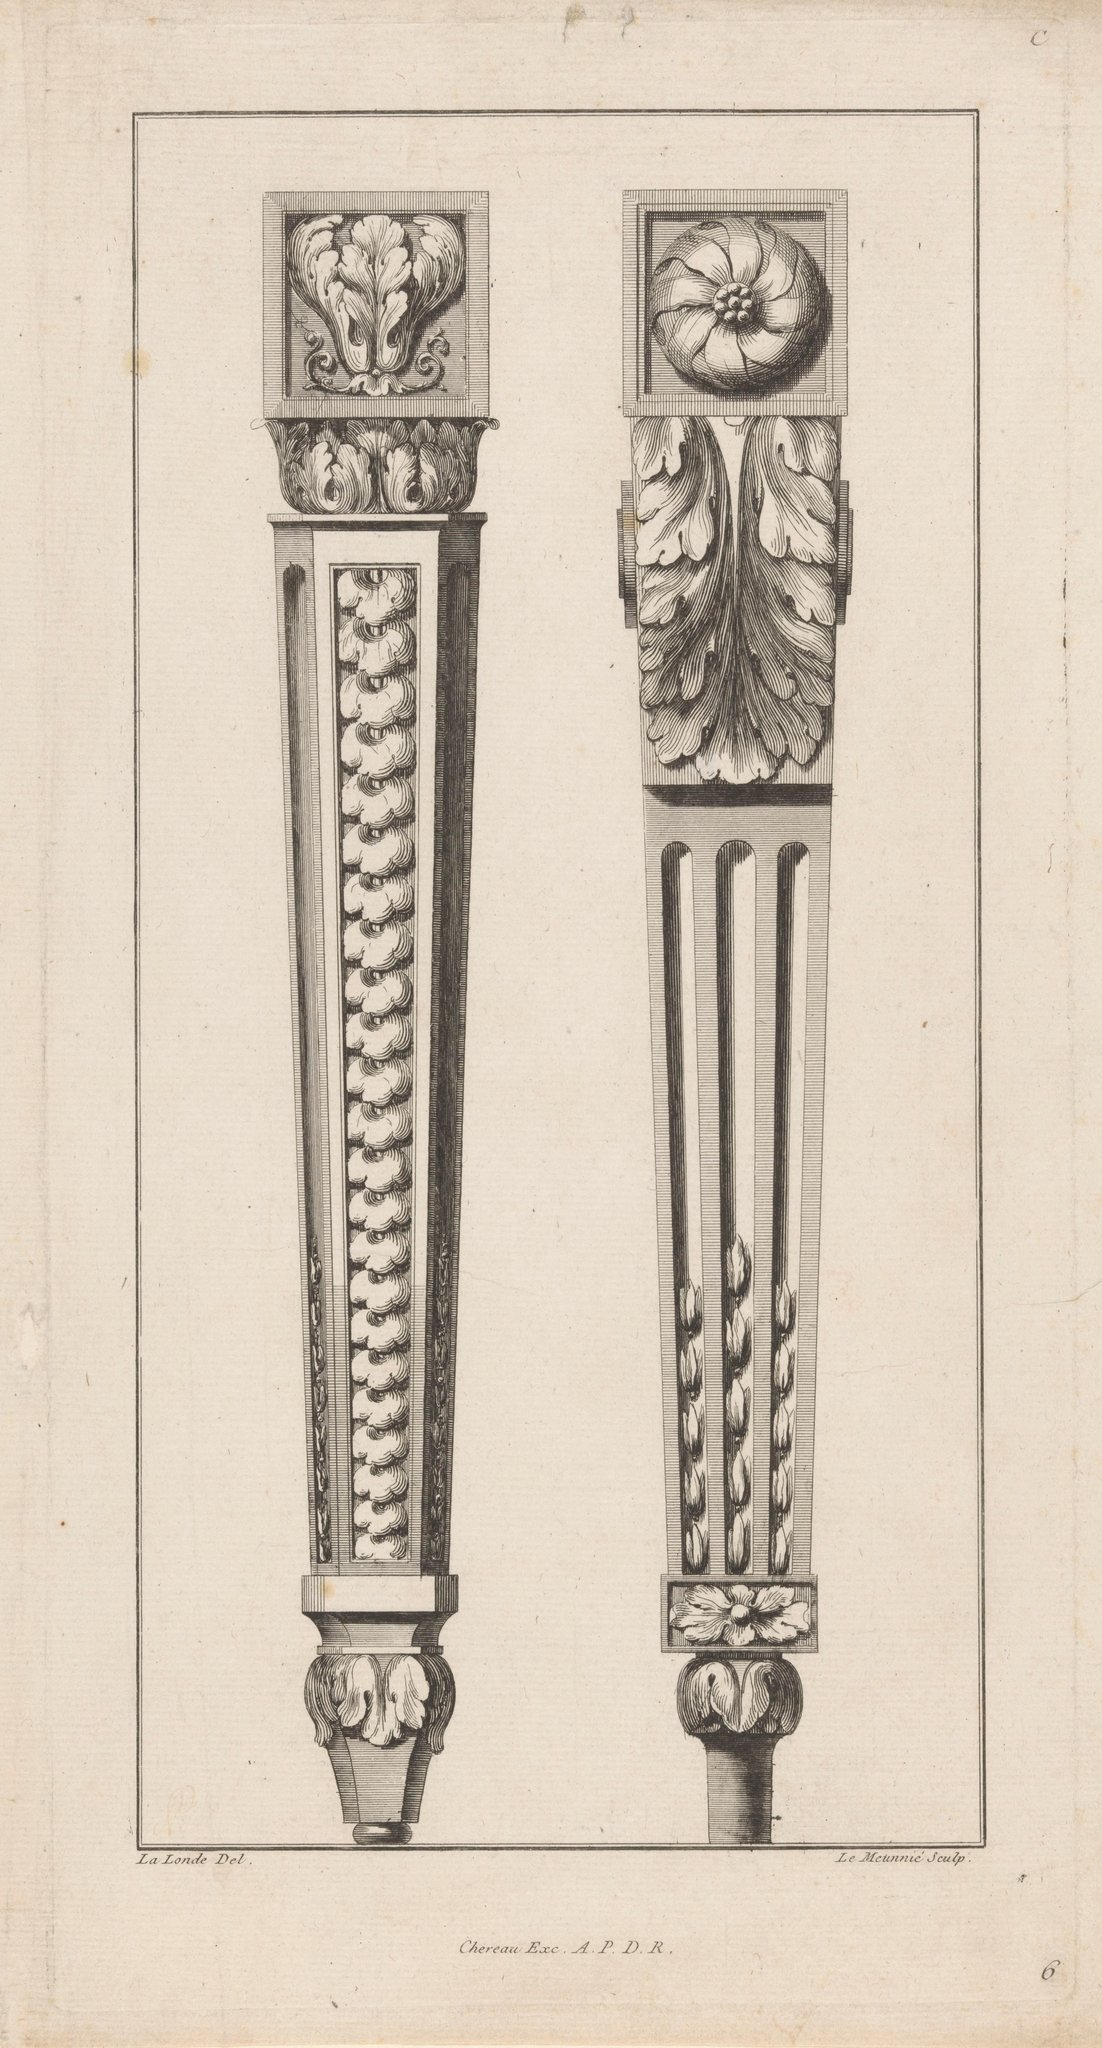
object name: print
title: Twee meubelpoten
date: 1784-1785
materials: paper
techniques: engraving, etching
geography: paris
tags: ornaments ~ art (+ framing decorations)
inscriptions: collector's mark: Lugt 2760, collector's mark: Lugt 2228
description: Twee geornamenteerde meubelpoten met bladmotieven.